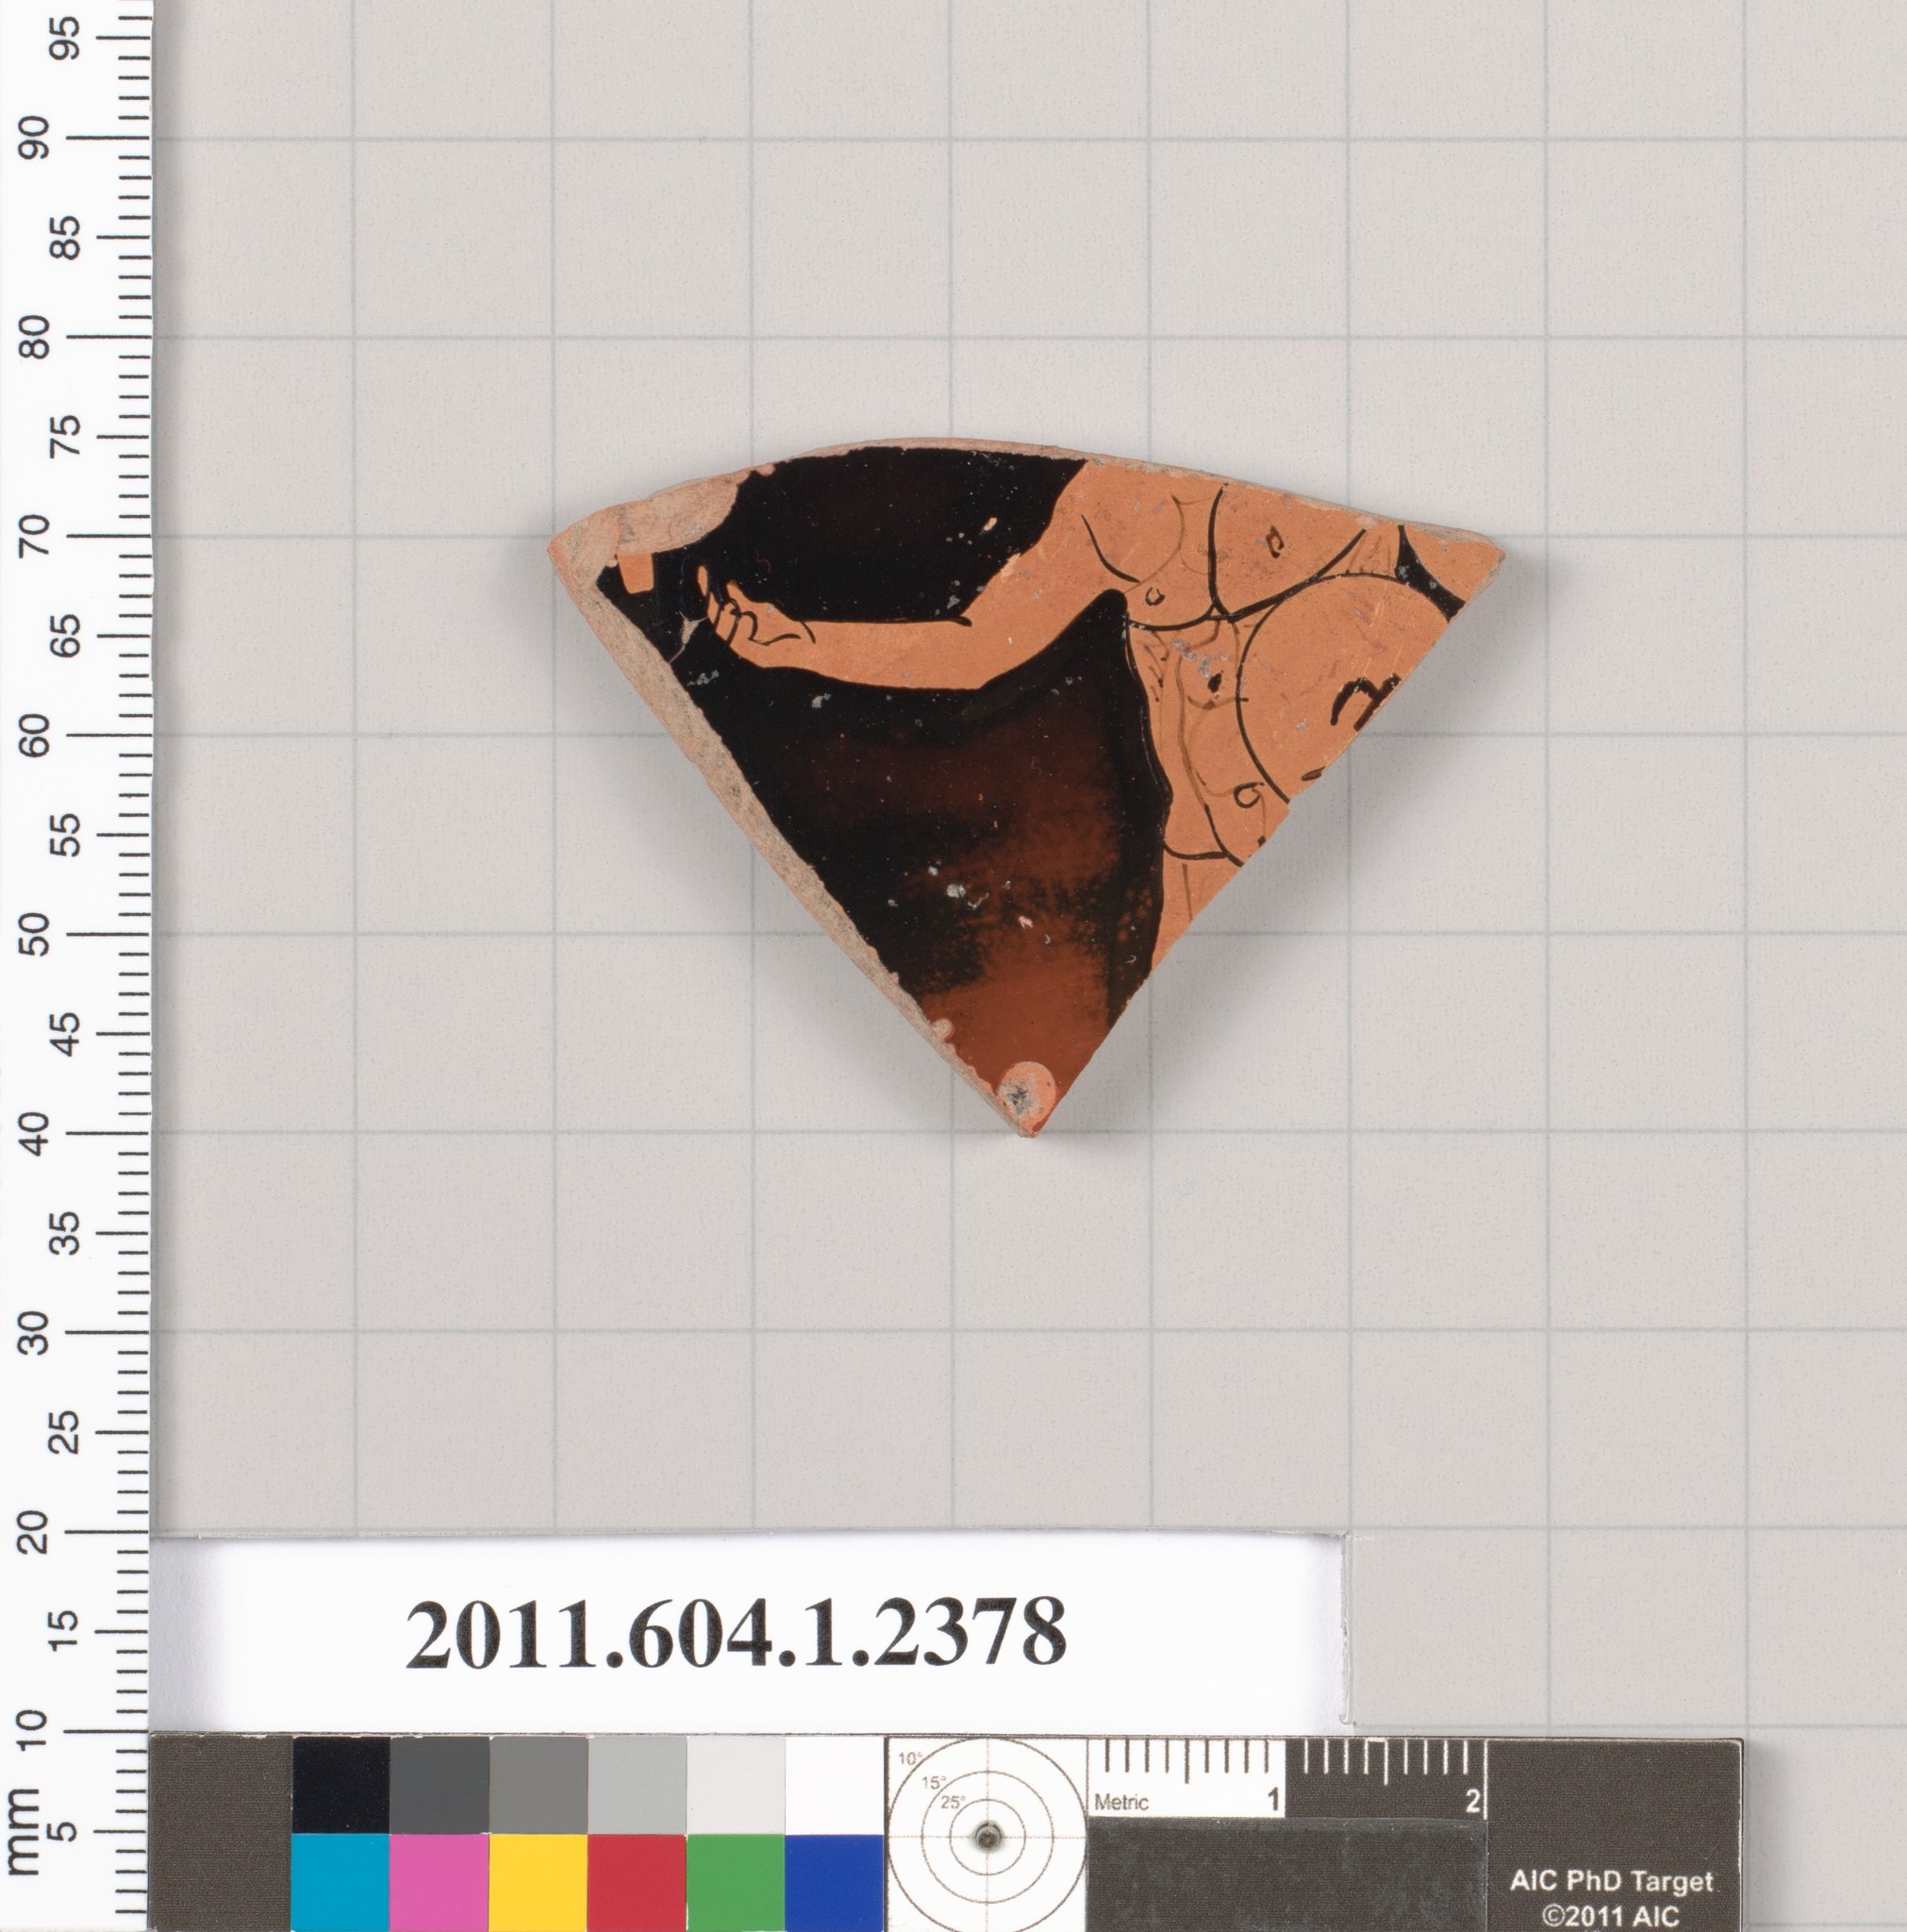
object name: kylix fragment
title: Terracotta fragment of a kylix (drinking cup)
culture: greek, attic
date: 475-451 BCE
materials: terracotta